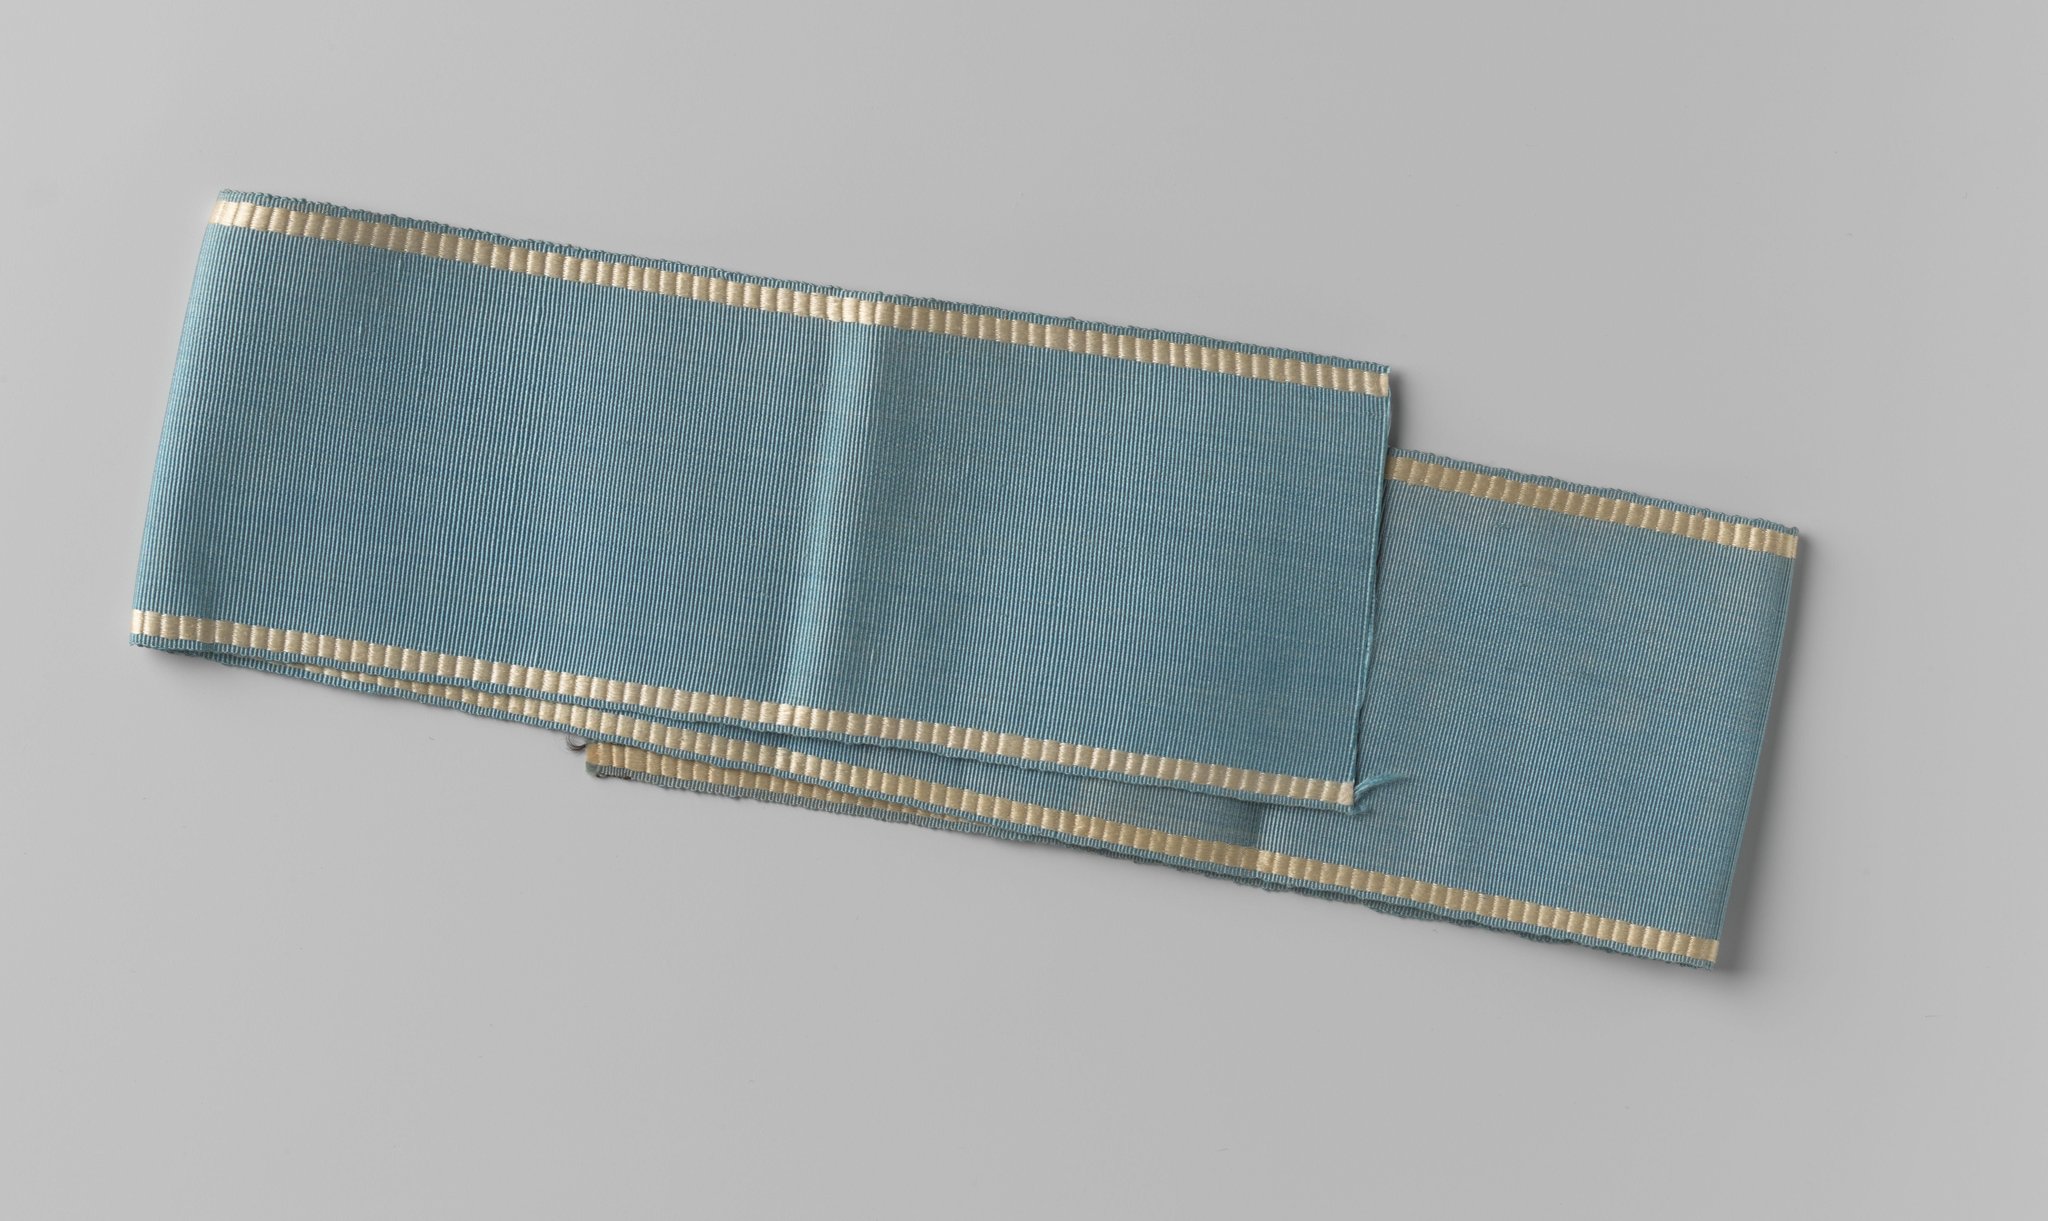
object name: ribbon material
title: Lint van blauwe zijde, afgezet met een witte bies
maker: Anonymous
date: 1600-1999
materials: silk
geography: western europe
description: Lint van blauwe zijde langs beide lange zijden afgezet met een witte (of verbleekt oranje) bies.